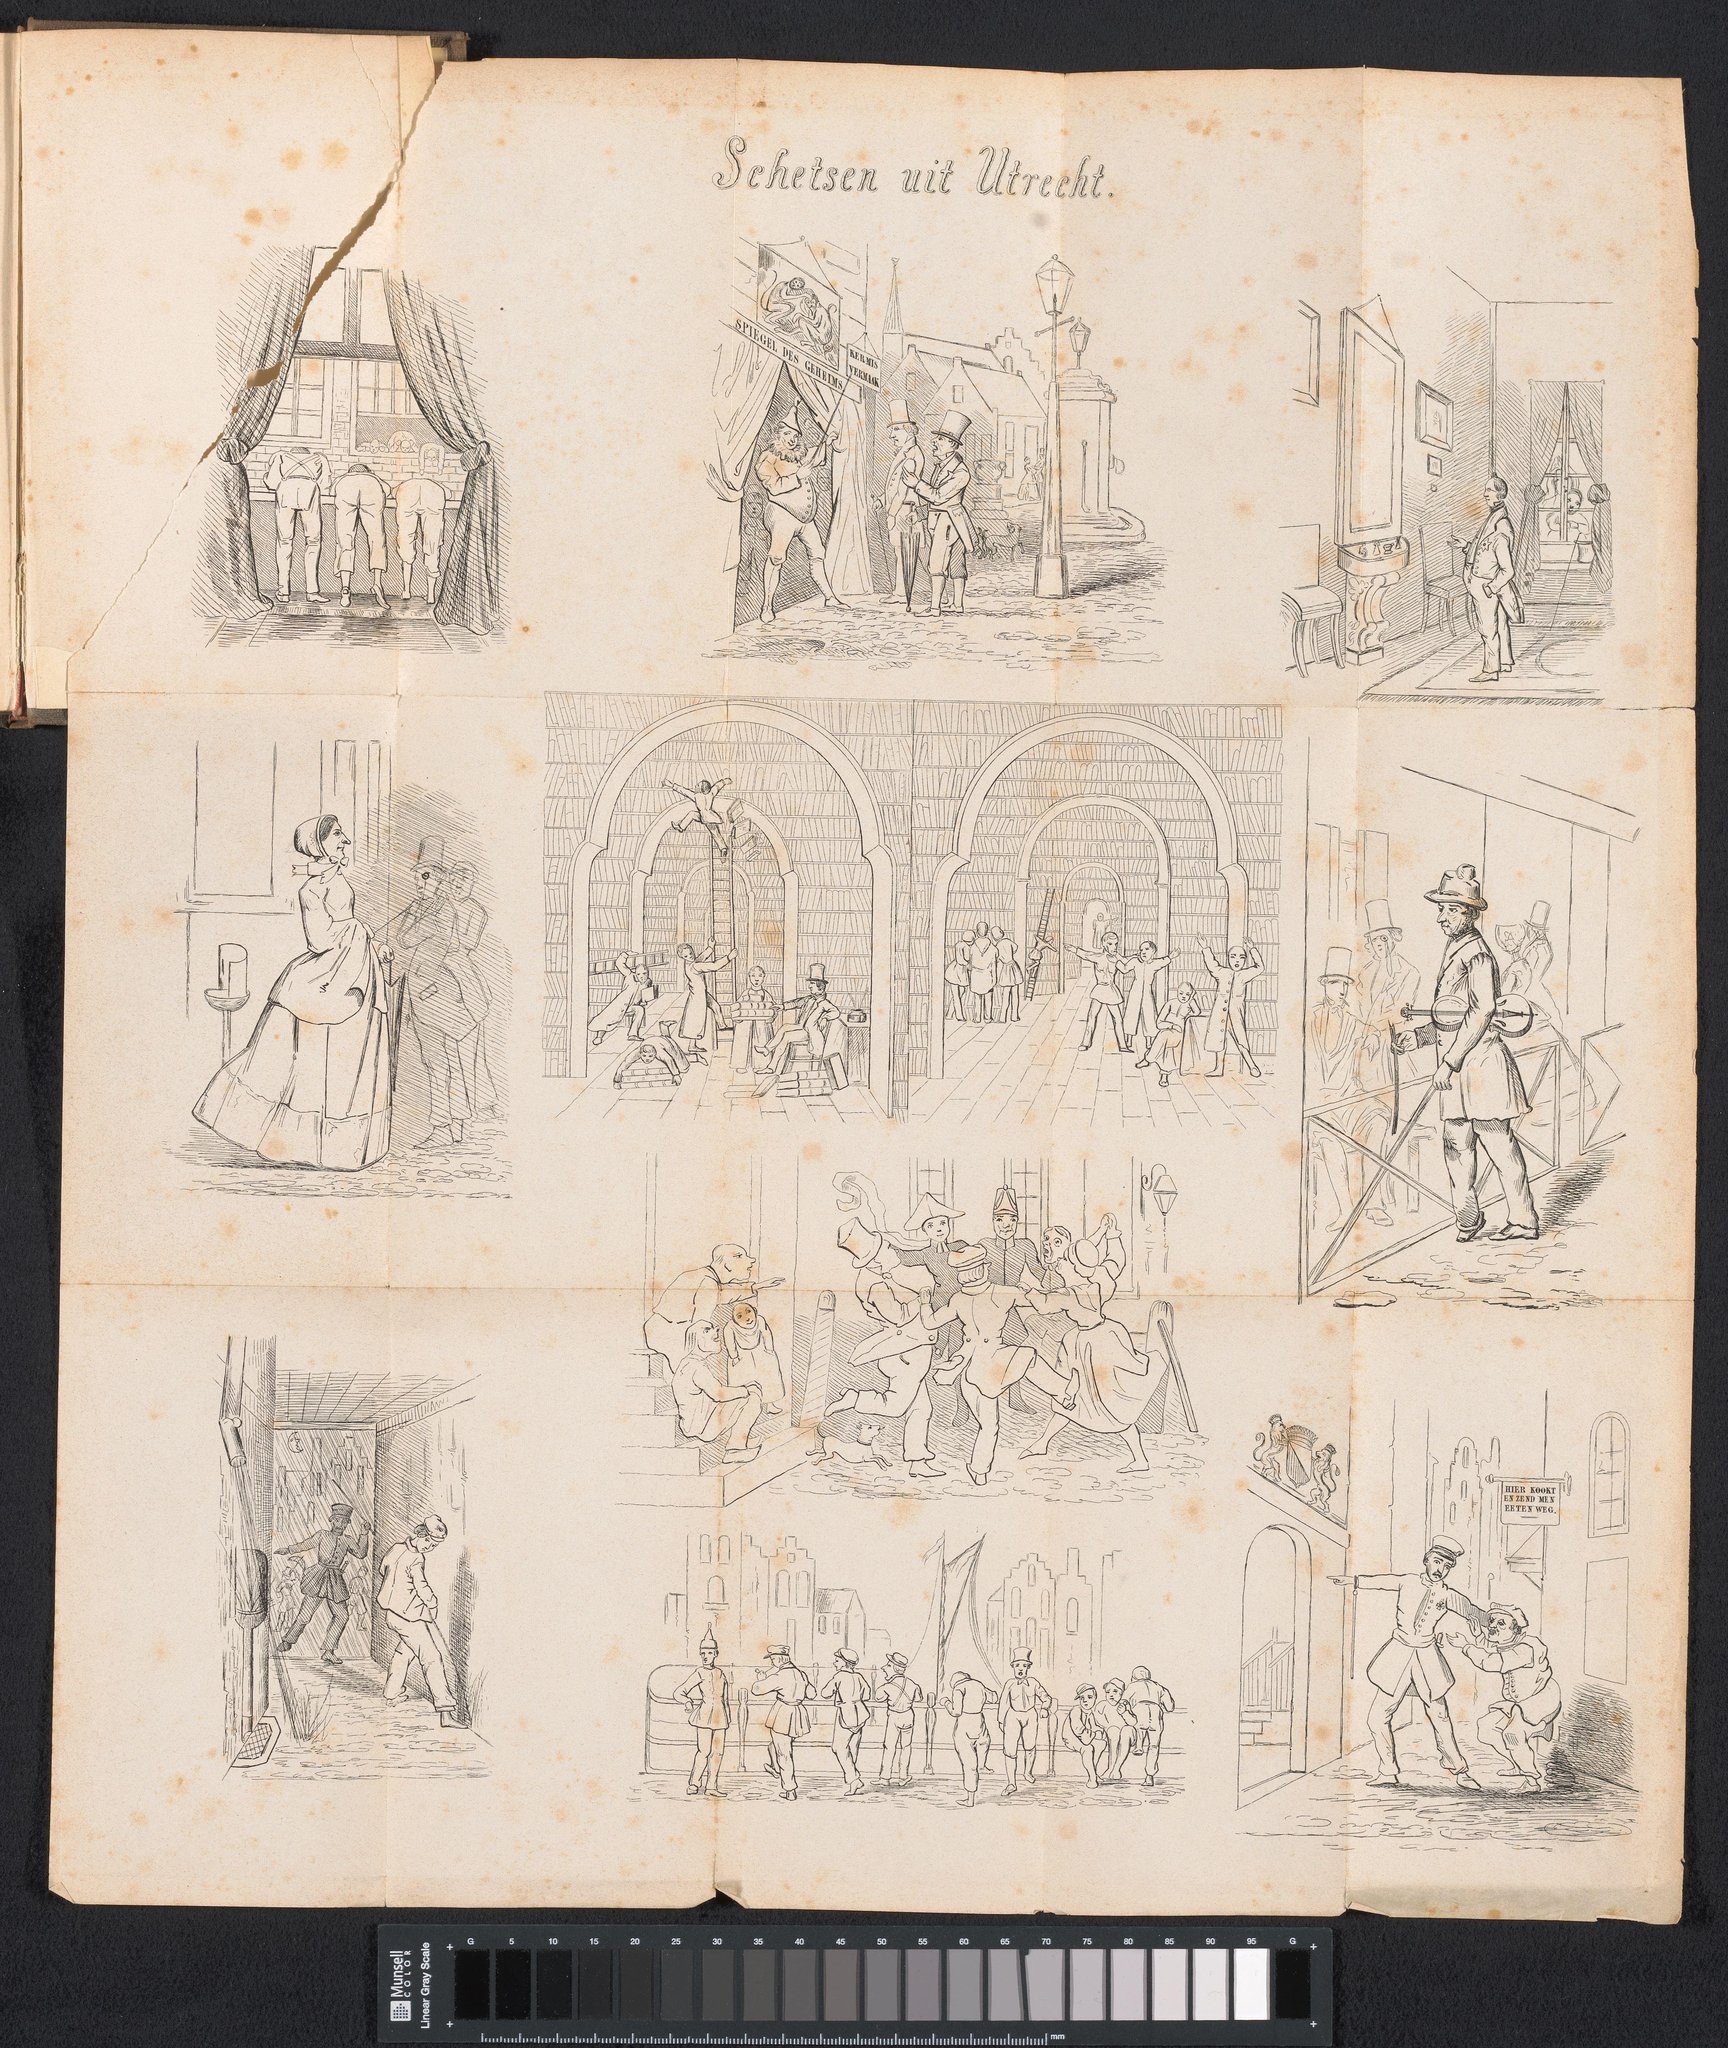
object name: print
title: Schetsen uit Utrecht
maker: Anonymous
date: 1857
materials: paper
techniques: lithograph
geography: netherlands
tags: student life, utrecht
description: Blad met elf voorstellingen uit het studentenleven. Centraal twee gezichten in de Utrechtse universiteitsbibliotheek. Spotprent in de studentenalmanak van de Universiteit van Utrecht van het jaar 1857